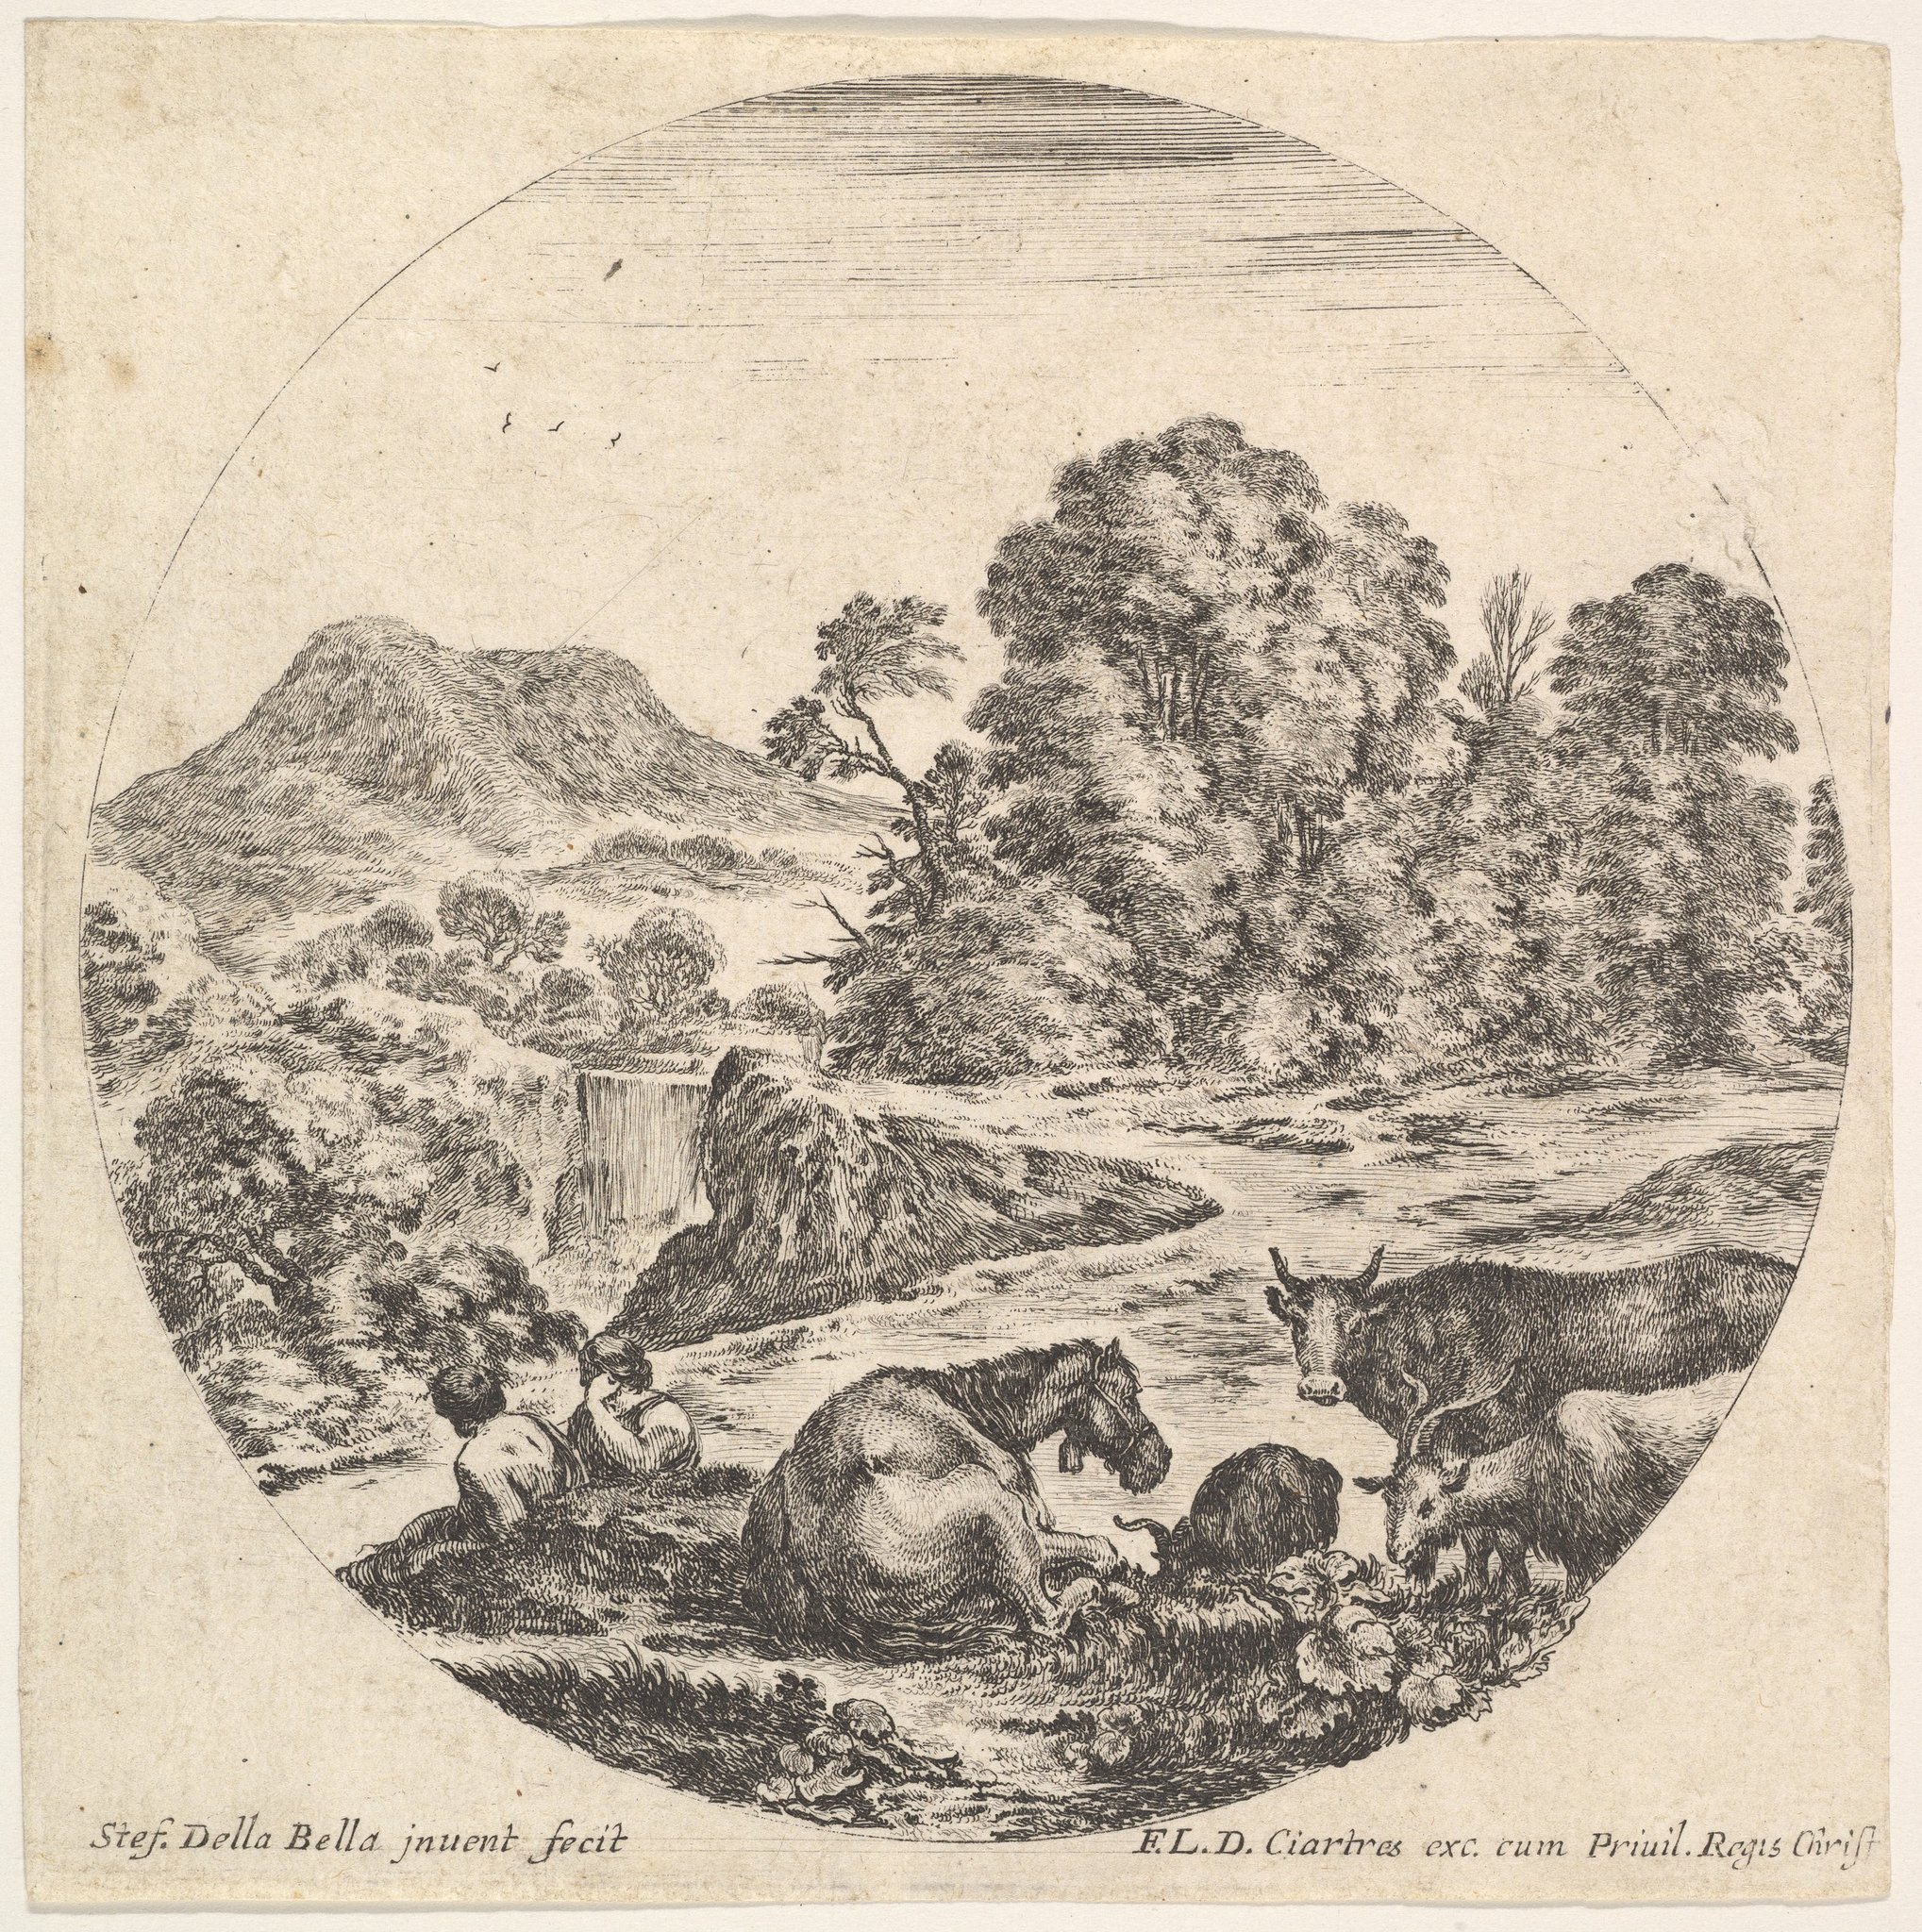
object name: print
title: Plate 10: a horse lying down, a cow and two goats, two seated shepherds, a waterfall and a mountain in the background, from "Roman landscapes and ruins" (Paysages et ruines de Rome)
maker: stefano della bella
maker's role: artist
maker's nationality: italian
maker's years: 1610-1664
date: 1643-1648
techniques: etching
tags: cows,goats,horses,mountains,shepherds